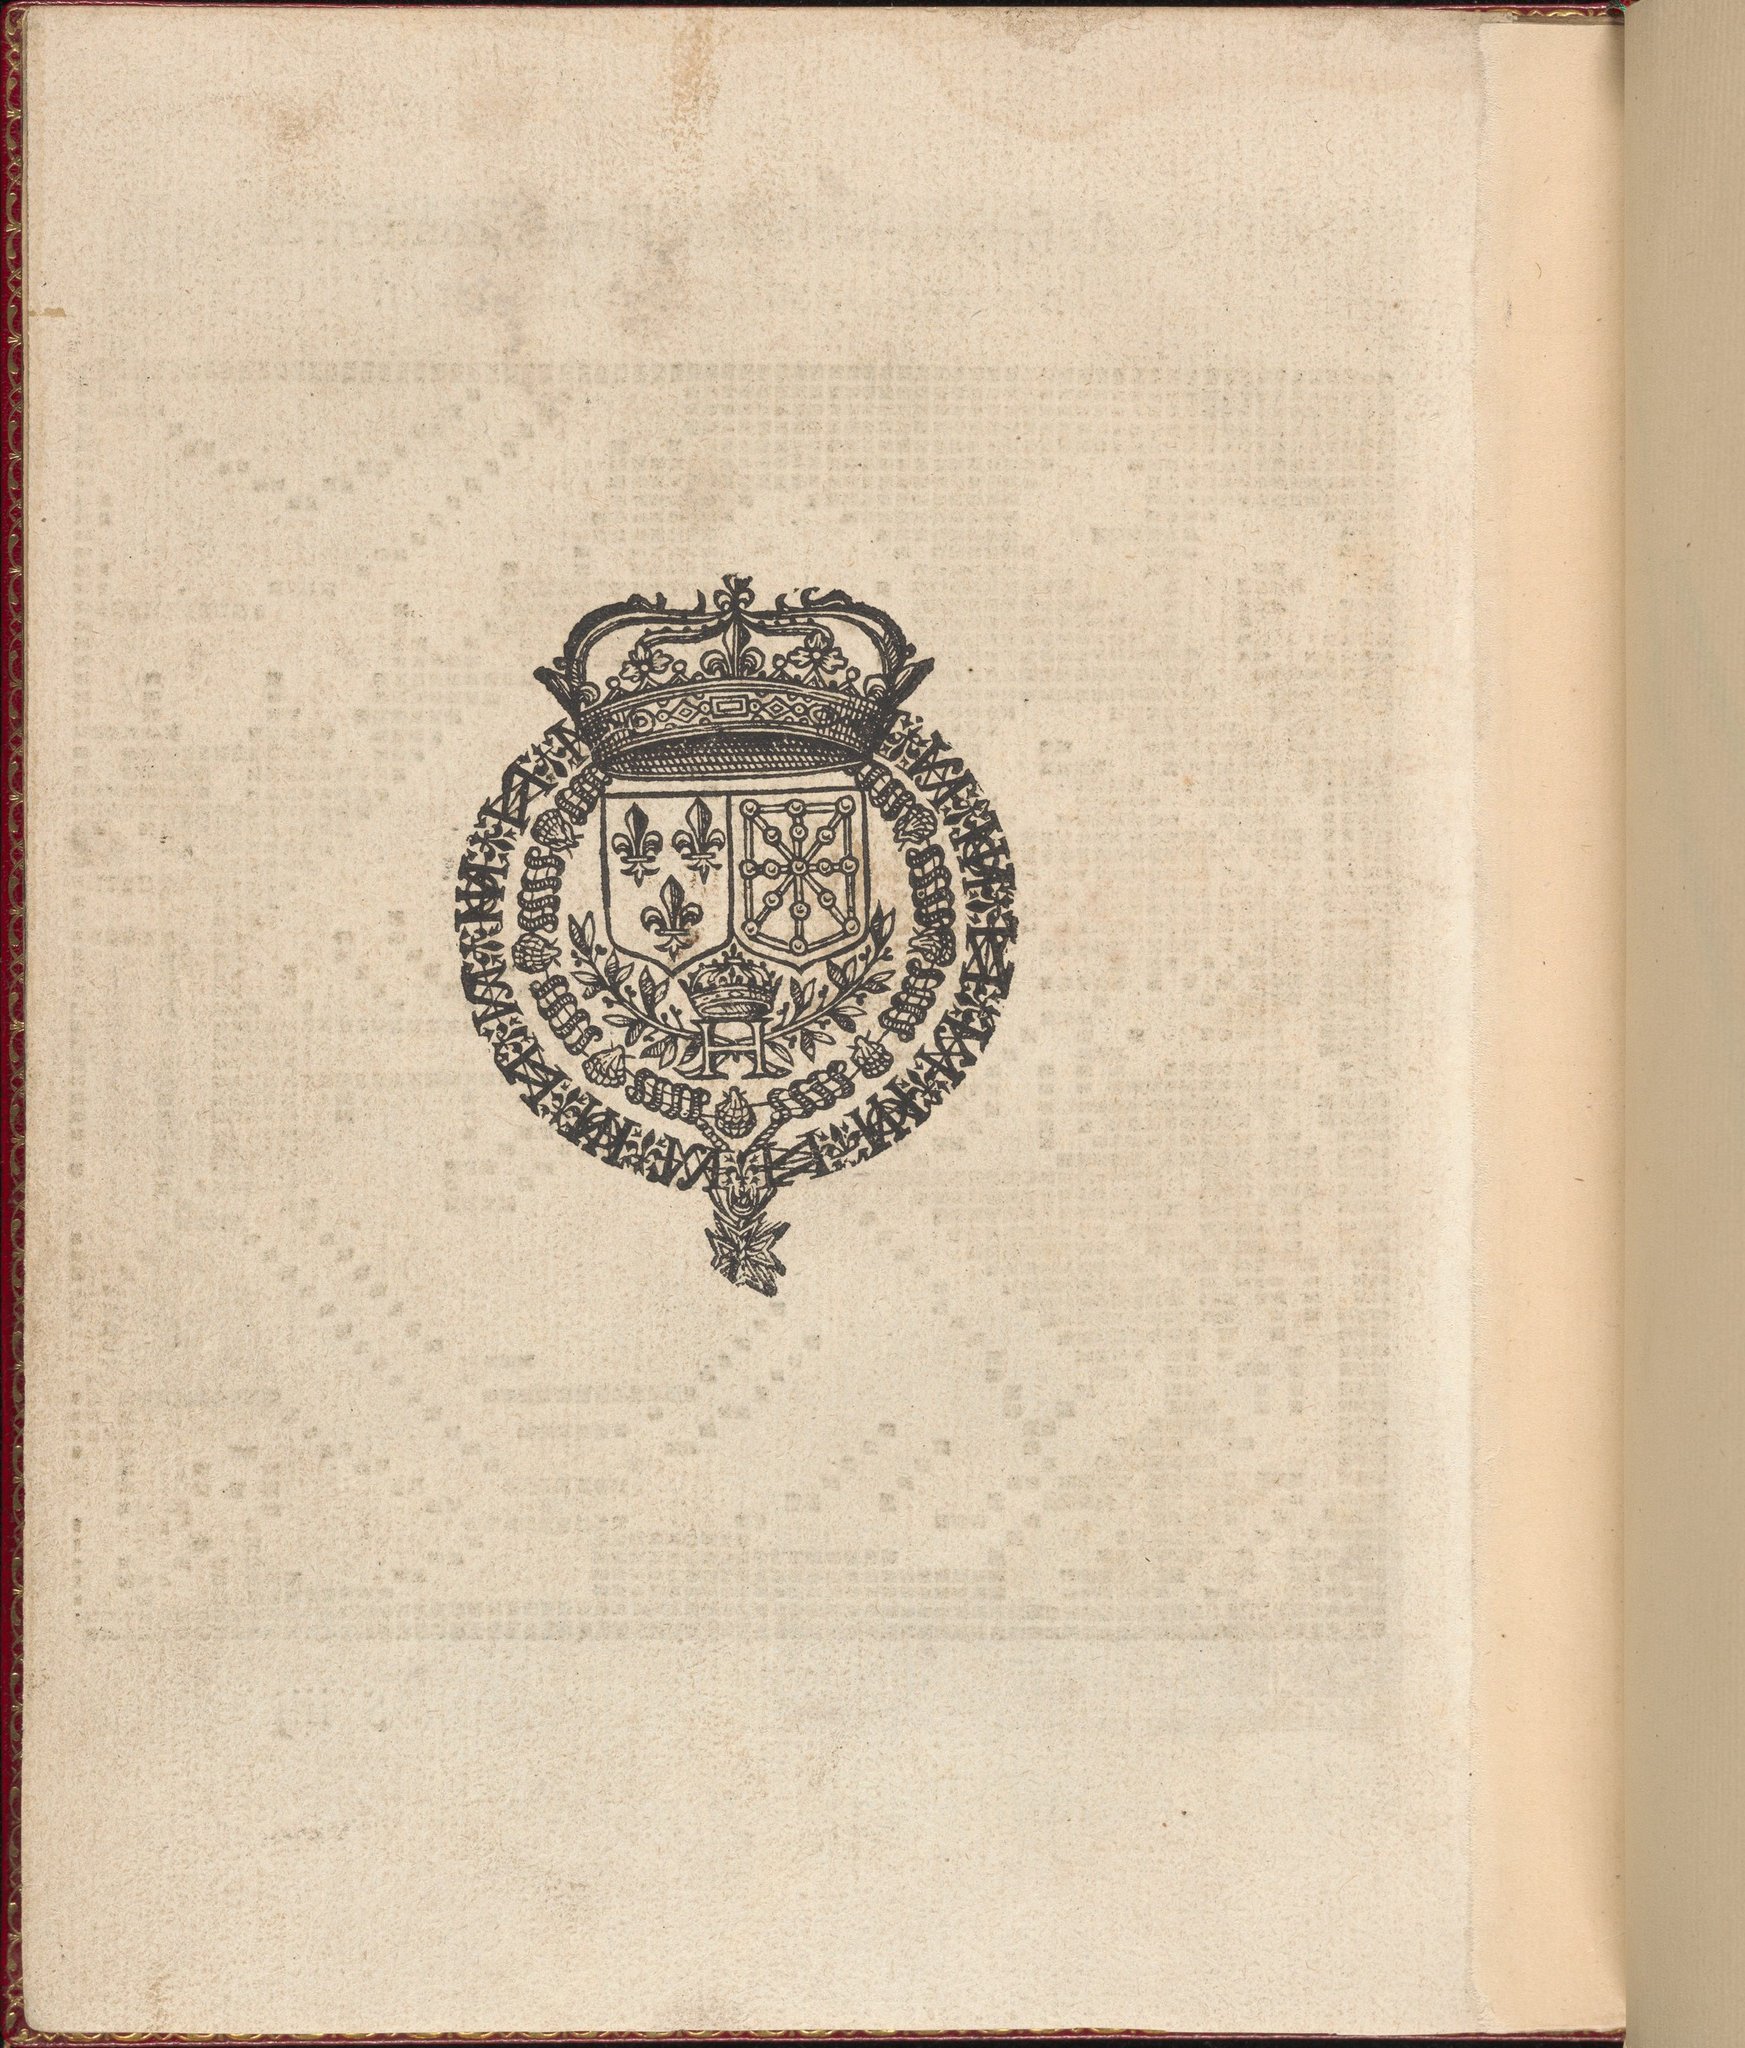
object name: book print ornament architecture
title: Les Singuliers et Nouveaux Portraicts... page 72 (verso)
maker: federico de vinciolo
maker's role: designer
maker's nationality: italian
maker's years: 1582-1599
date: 1588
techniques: woodcut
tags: coat of arms